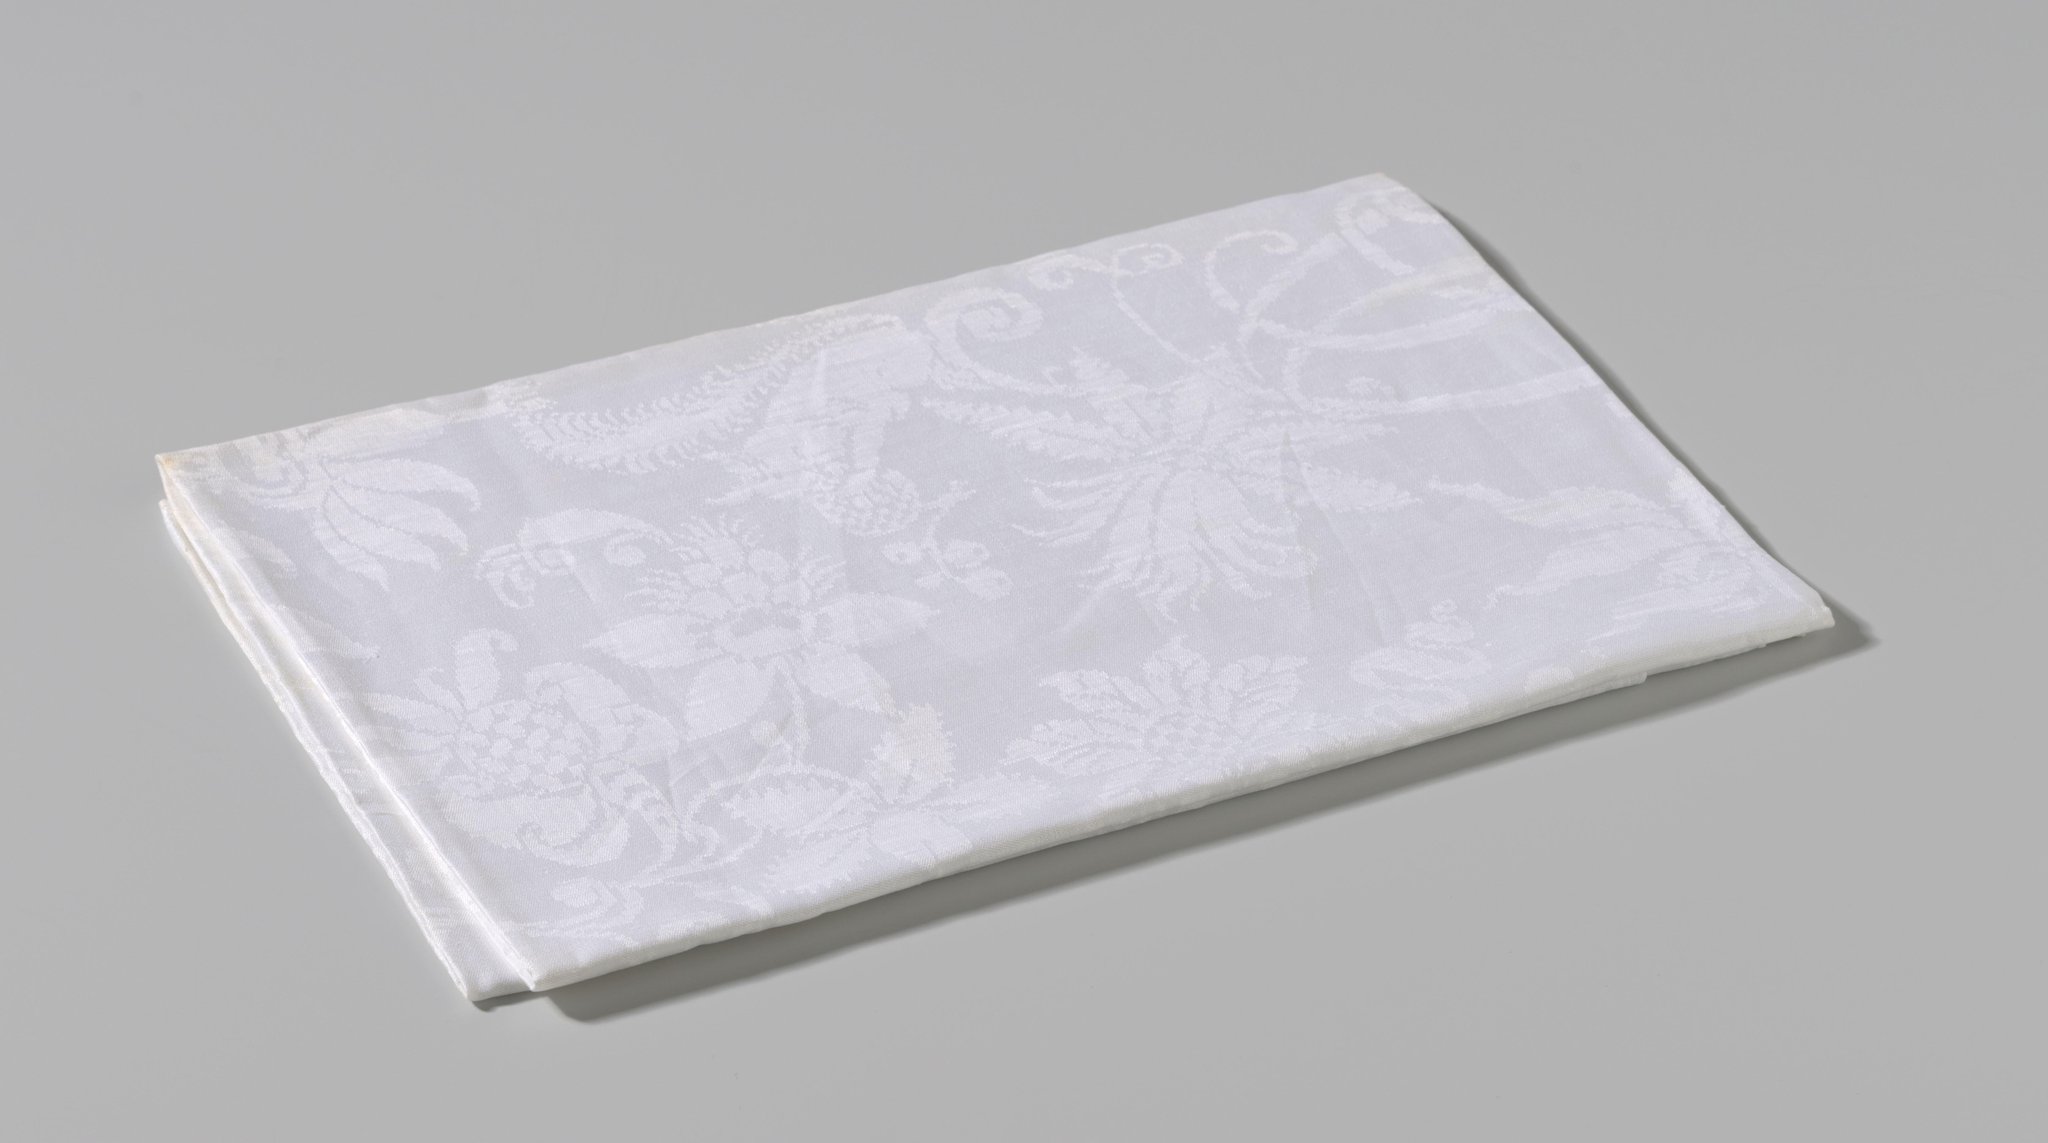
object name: napkin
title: Servet van linnendamast met een bloempatroon en wapens Rutgers en Block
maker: Anonymous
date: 1875-1900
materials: linen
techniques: damask, weave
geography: netherlands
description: Servet van linnendamast met bloemen, bladeren, vruchten aan takken, een ooievaar, een eekhoorn en een vlinder. In het midden het monogram DRMB, in de bovenhoeken het wapen van Rutgers en in de benedenhoeken het wapen van Block. Het servet hoort bij vijf servetten (BK-1973-194-A t/m BK-1973-194-F) die zijn gemaakt voor David Rutgers (1629-1707) en zijn vrouw Margaretha Block (1638-1702).